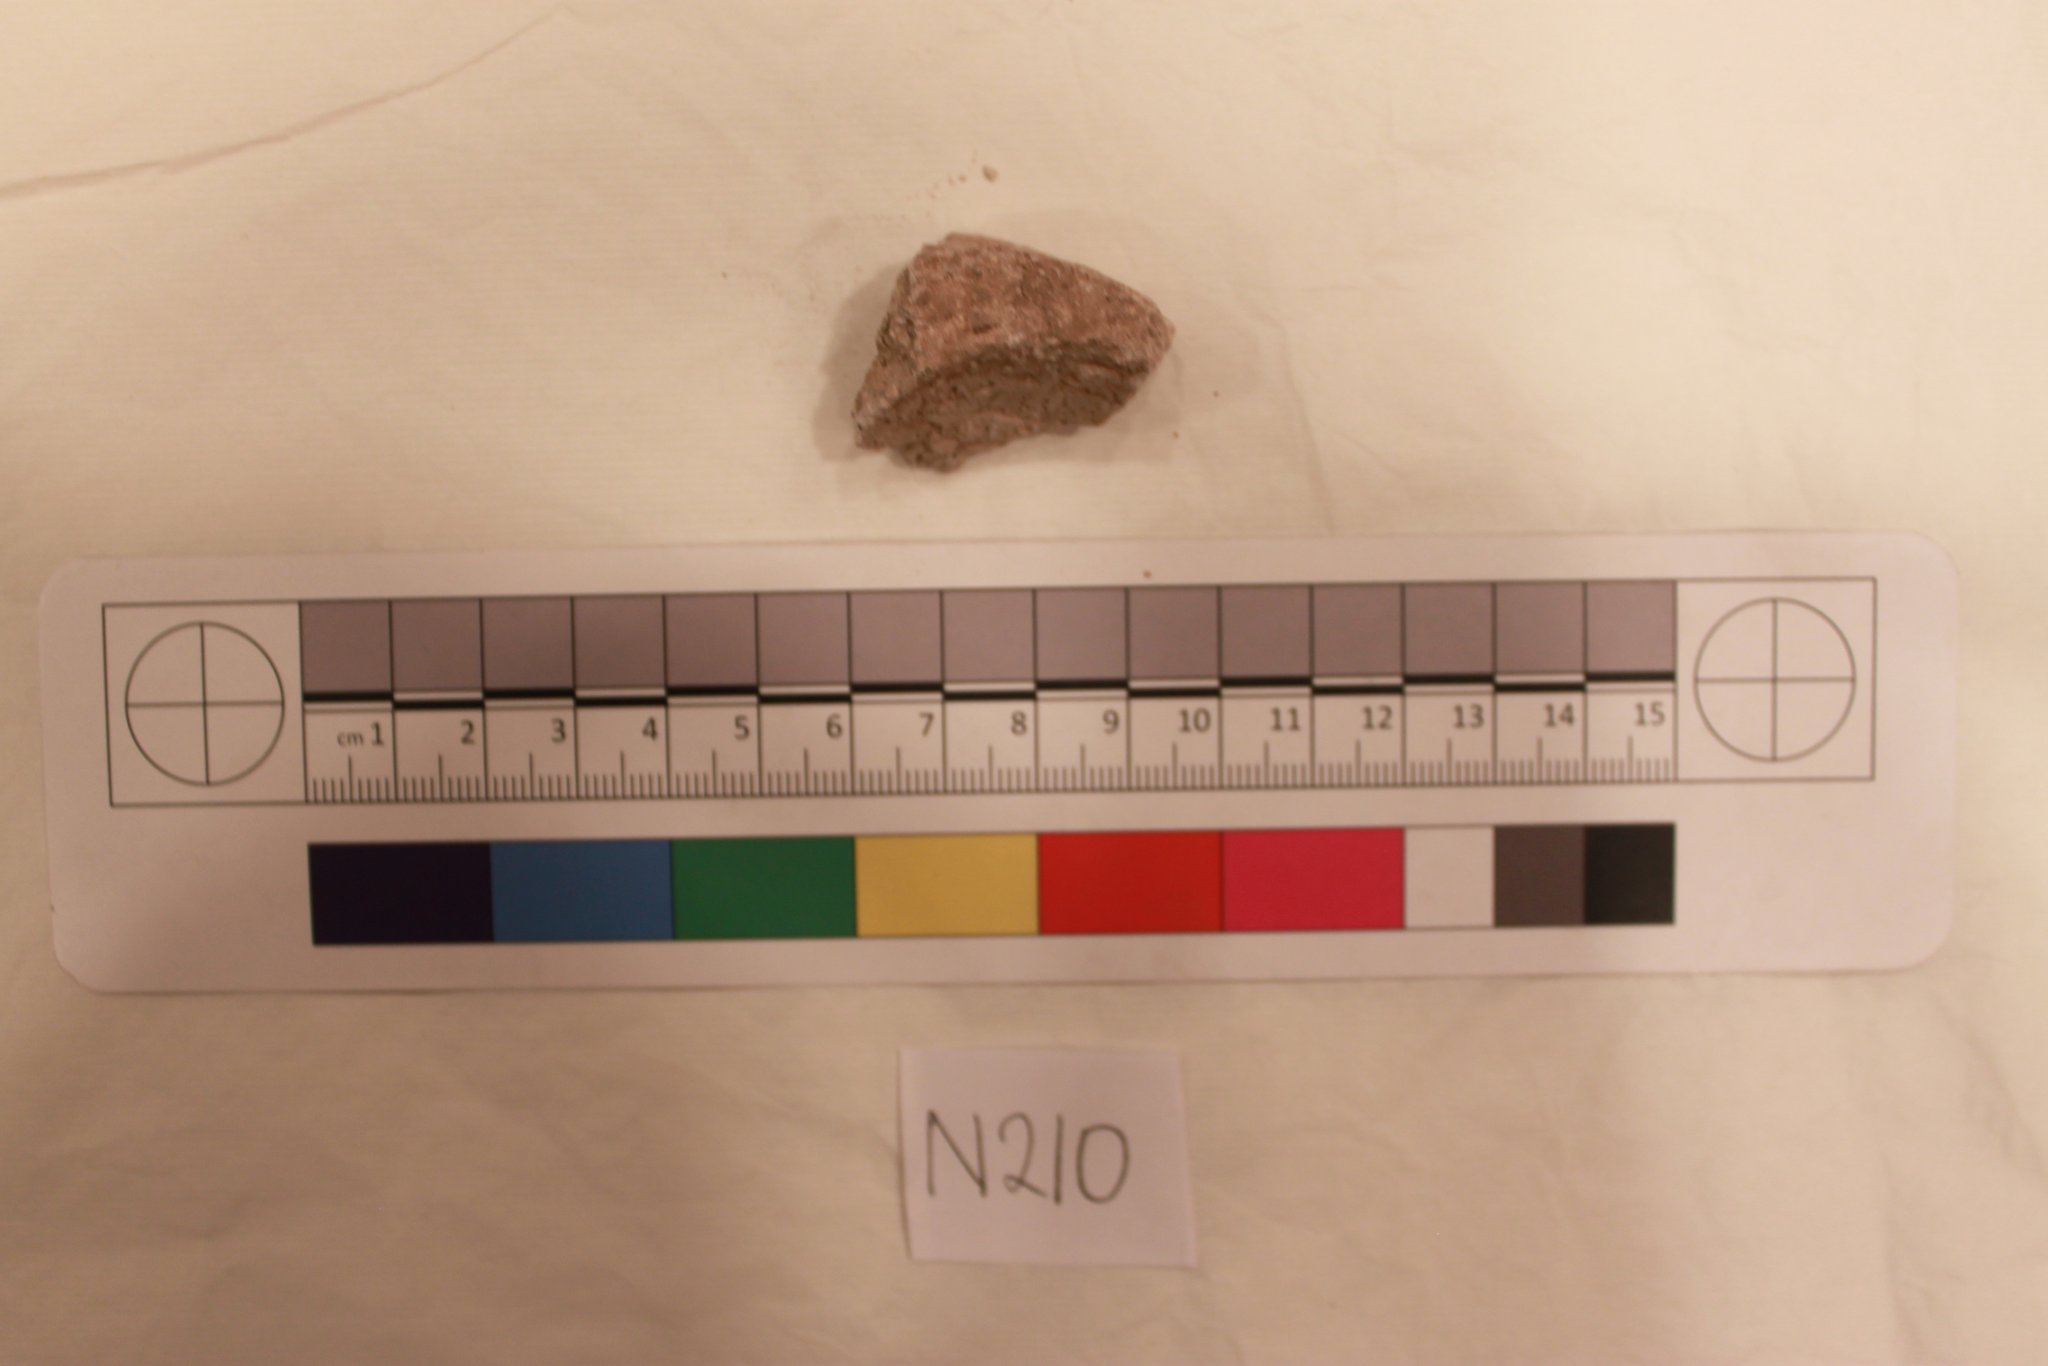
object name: fragment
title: Stucco Fragment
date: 701-1200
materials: plaster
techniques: carving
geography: iran